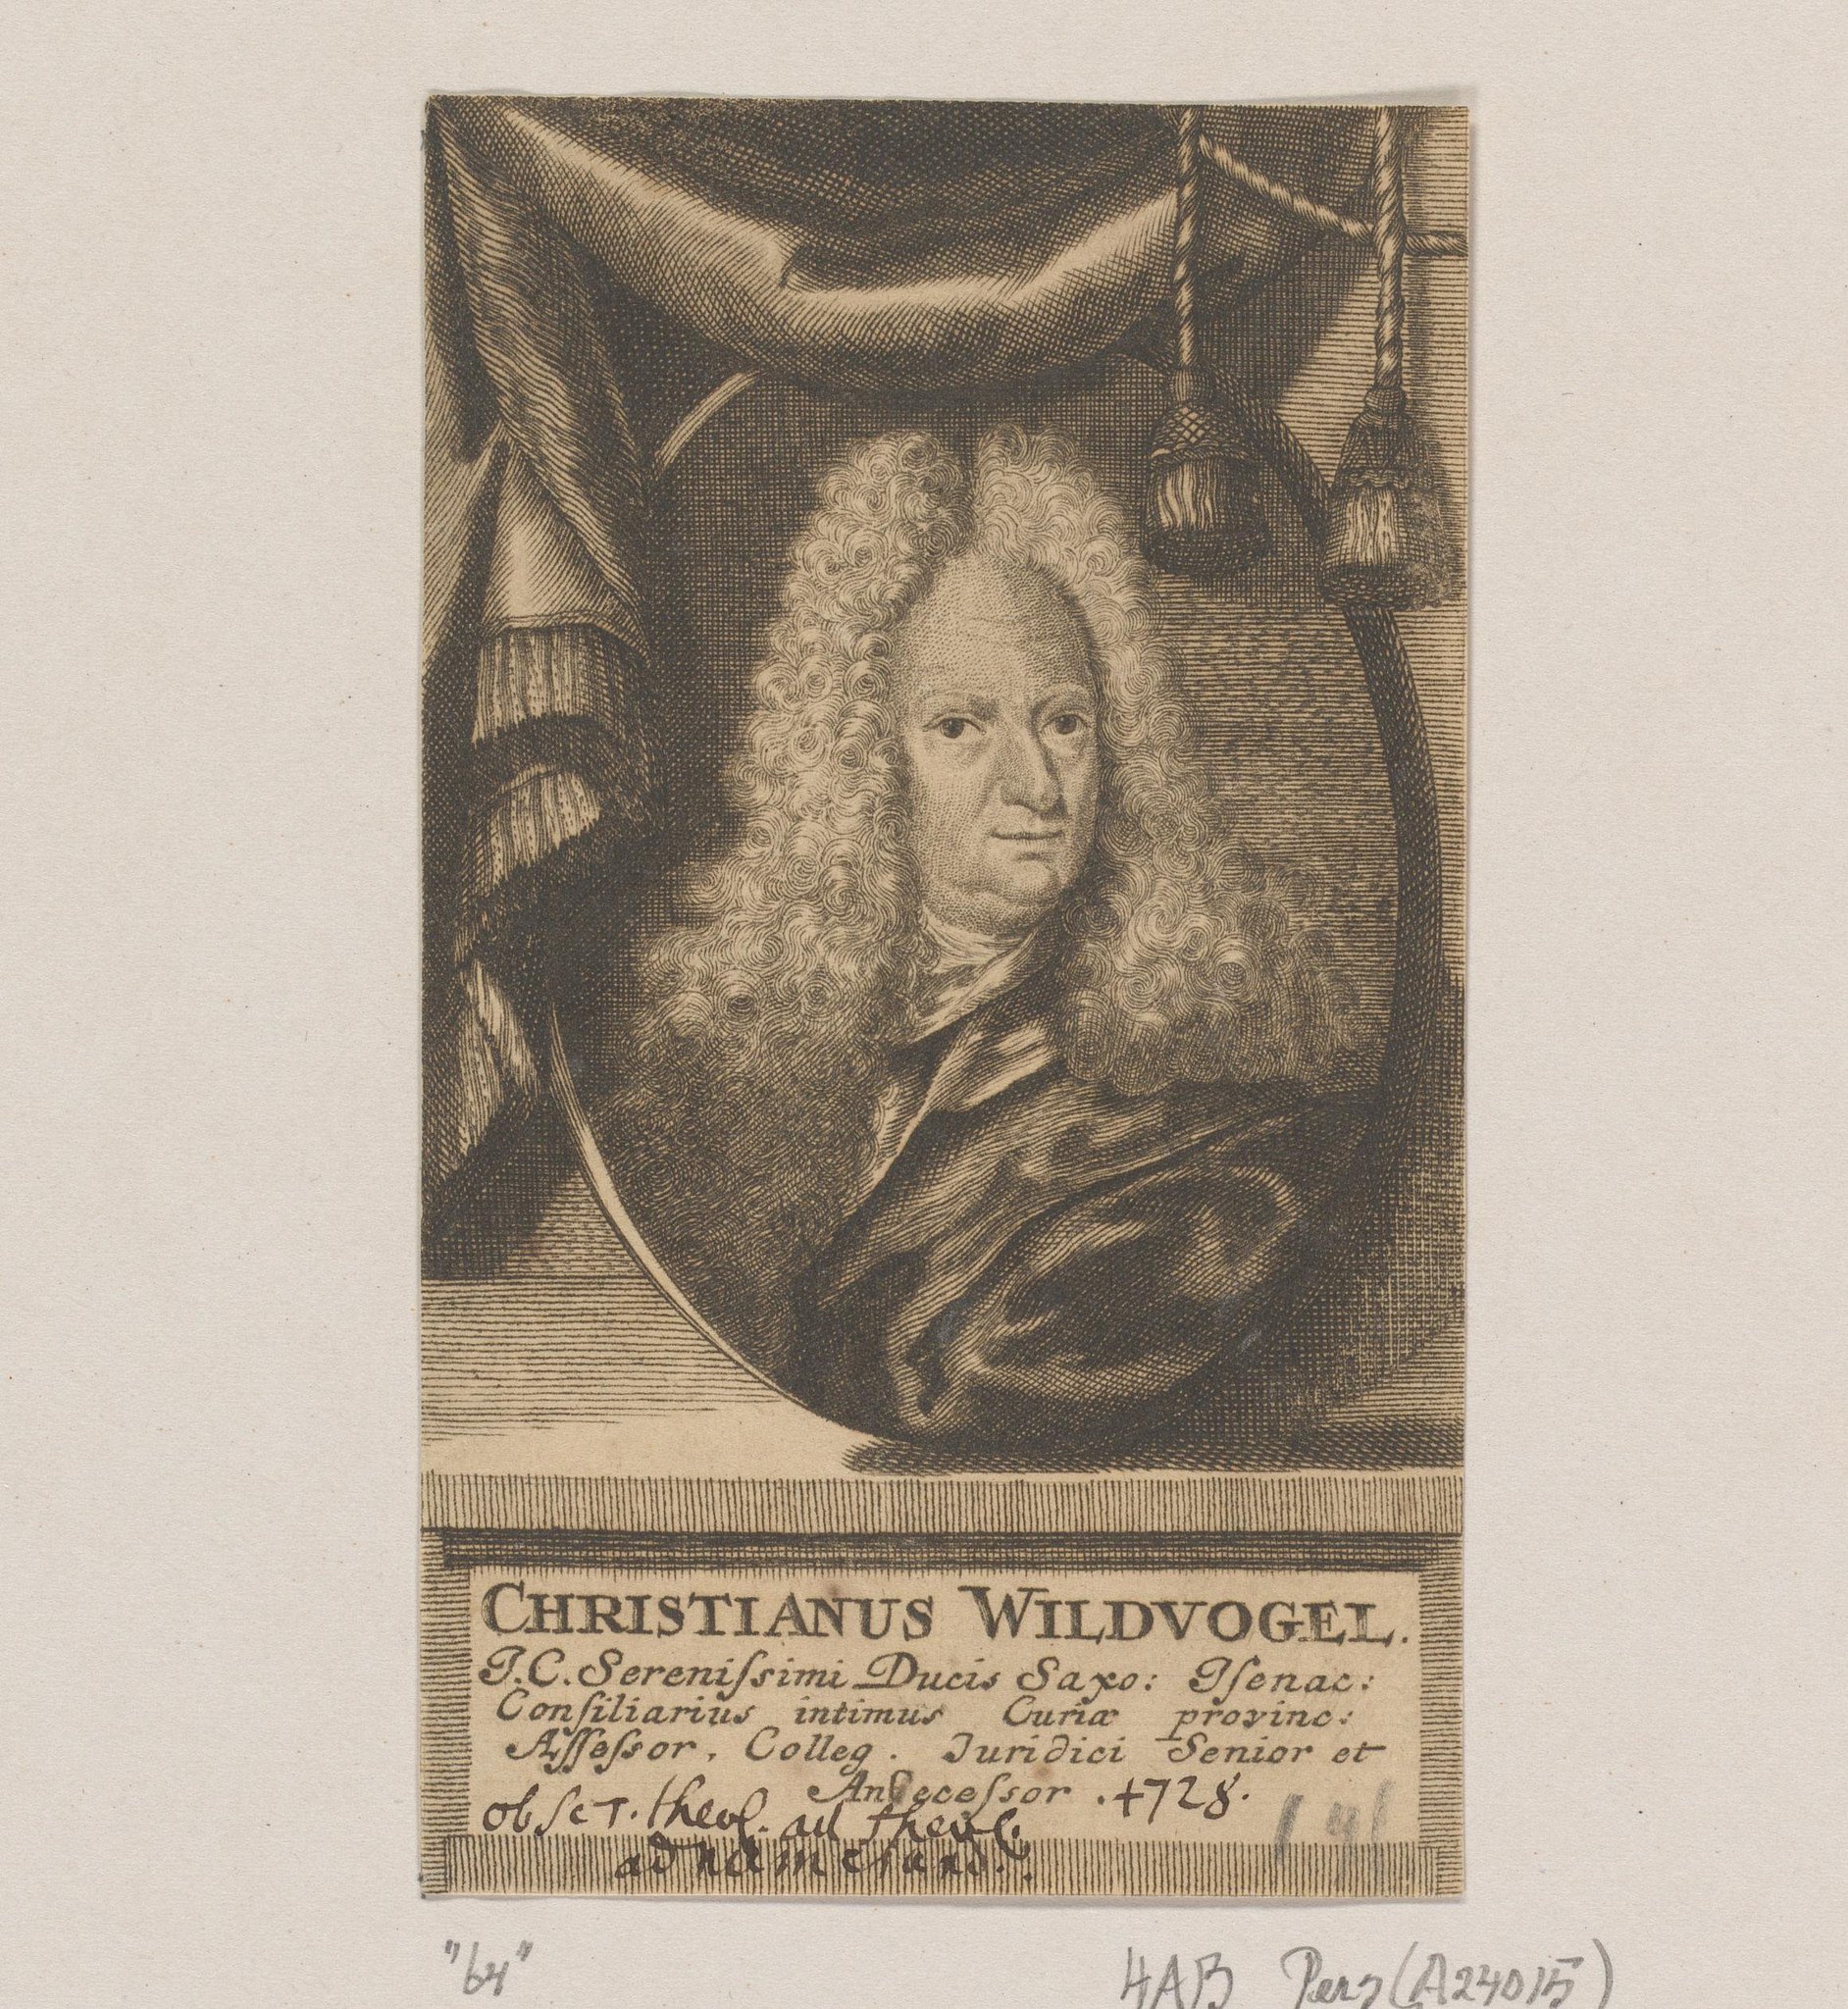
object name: print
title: Portret van Christian Wildvogel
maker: Anonymous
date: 1676-1728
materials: paper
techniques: etching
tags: christian wildvogel, historical persons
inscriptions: number: ‘64’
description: Met vierregelig onderschrift in het Latijn.